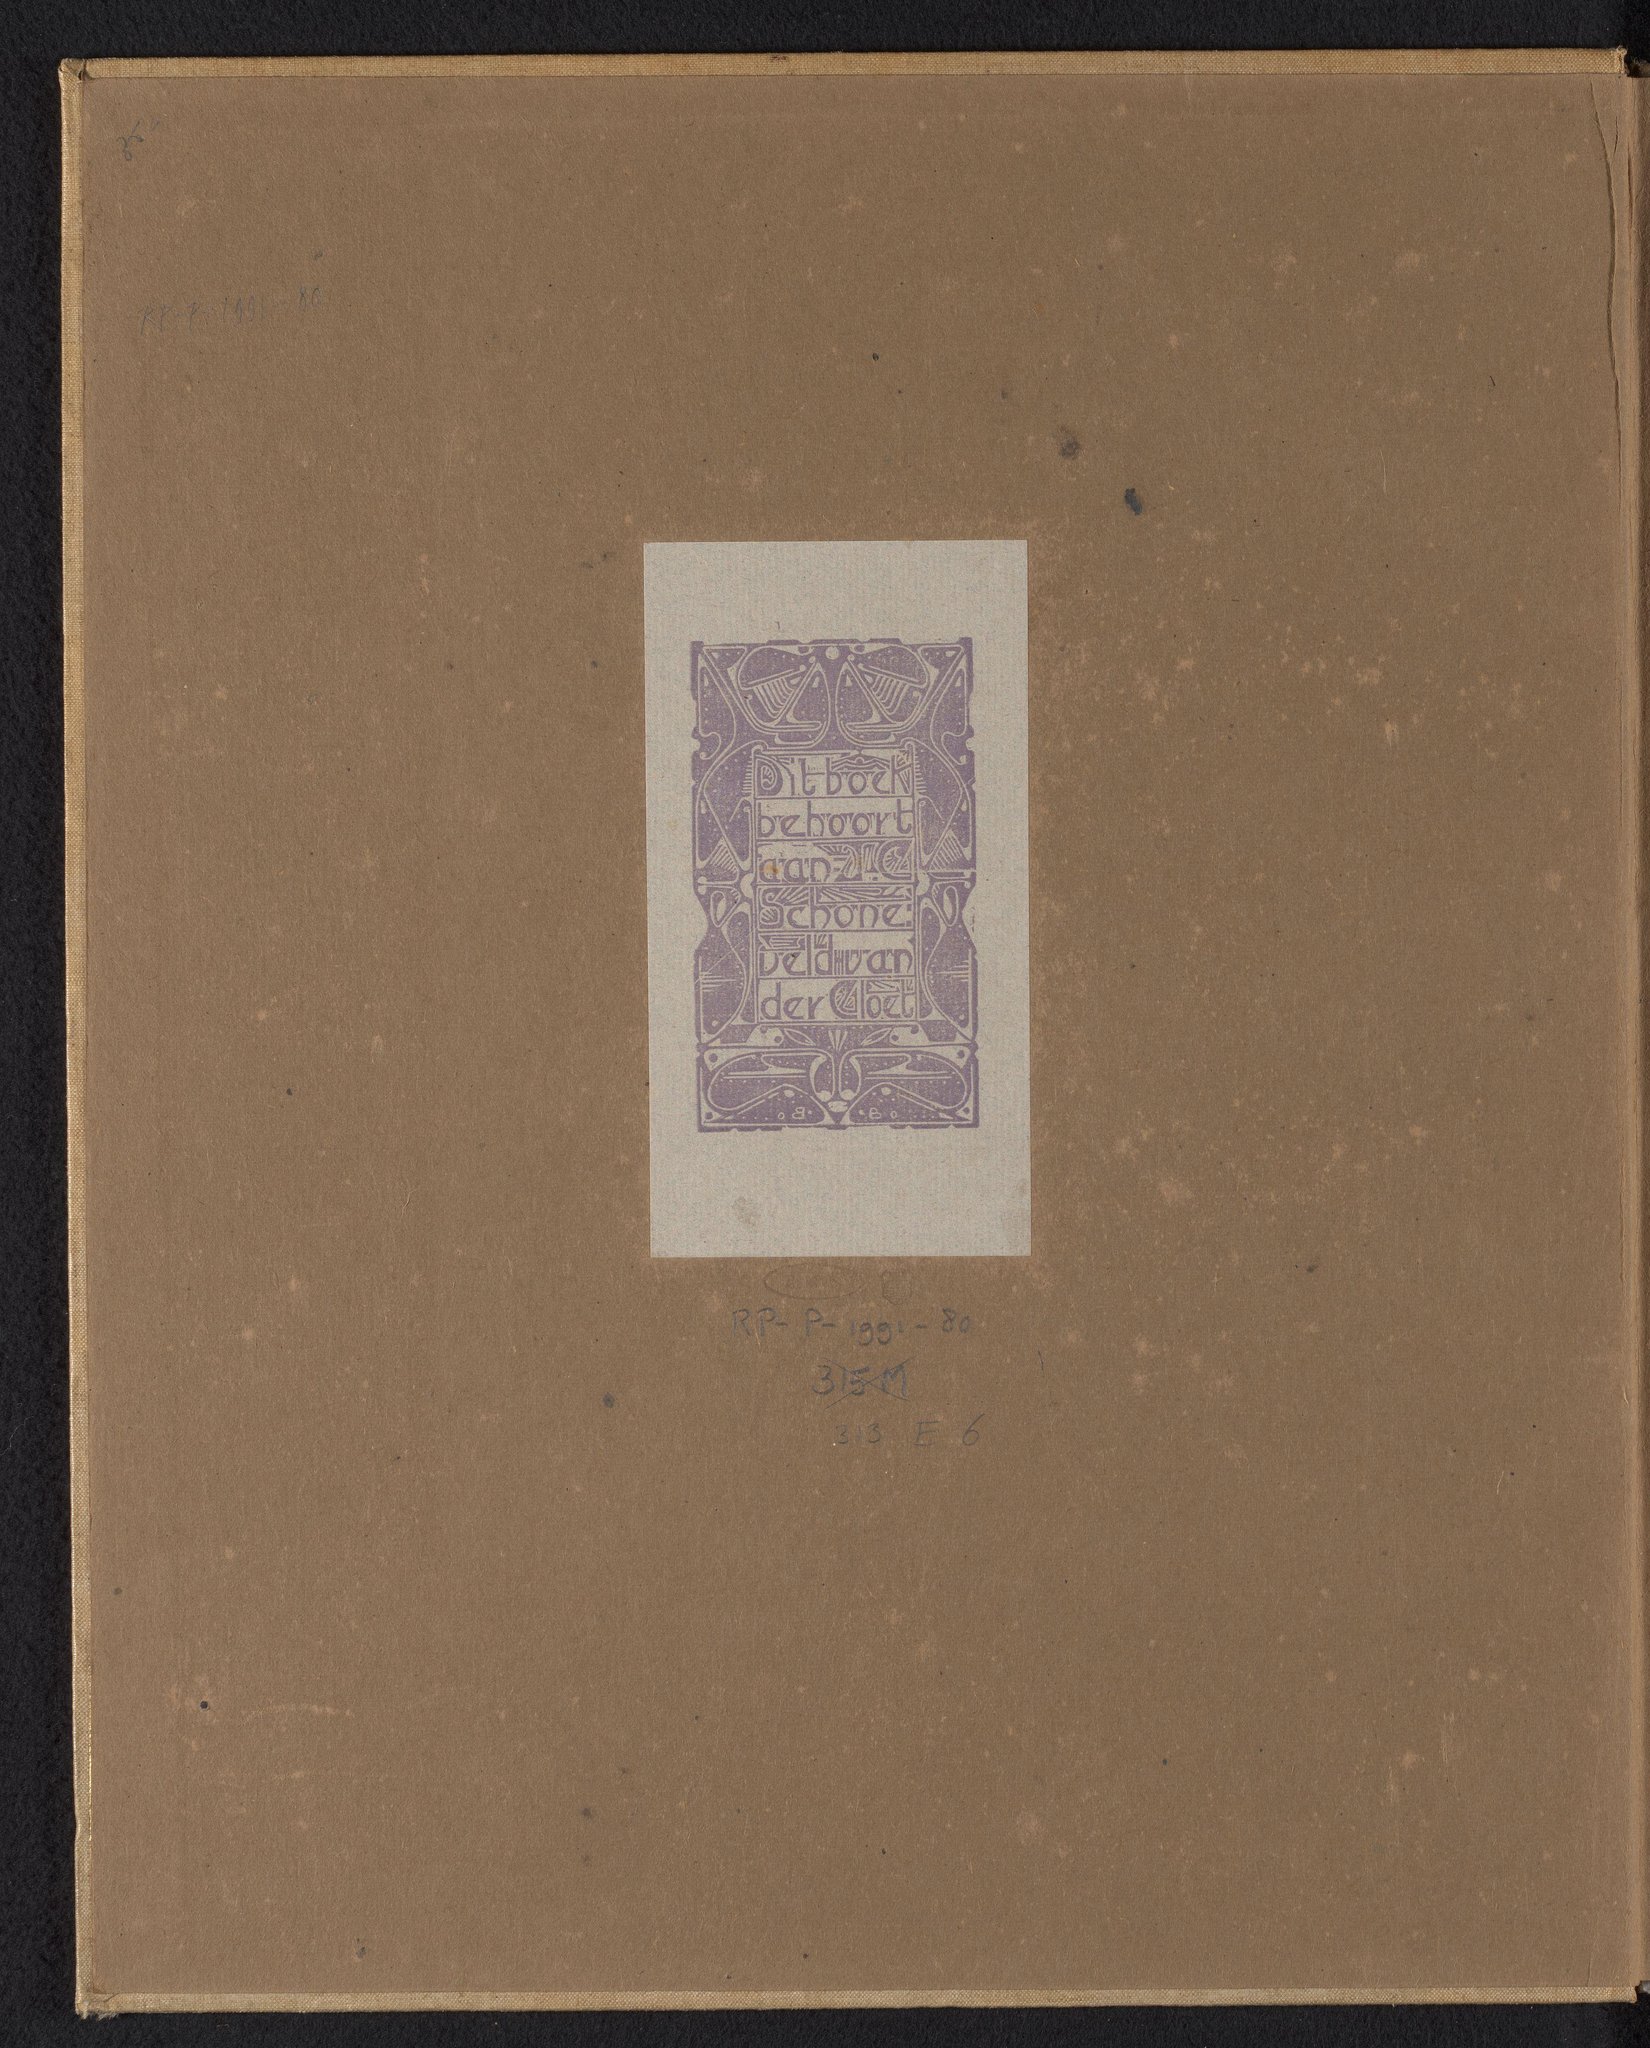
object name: bookplate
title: Ex libris van J.G. Schoneveld van der Gloet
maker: Anonymous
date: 1898-1991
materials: paper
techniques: woodcut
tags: ex-libris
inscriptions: collector's mark: Lugt 2760, collector's mark: Lugt 2228